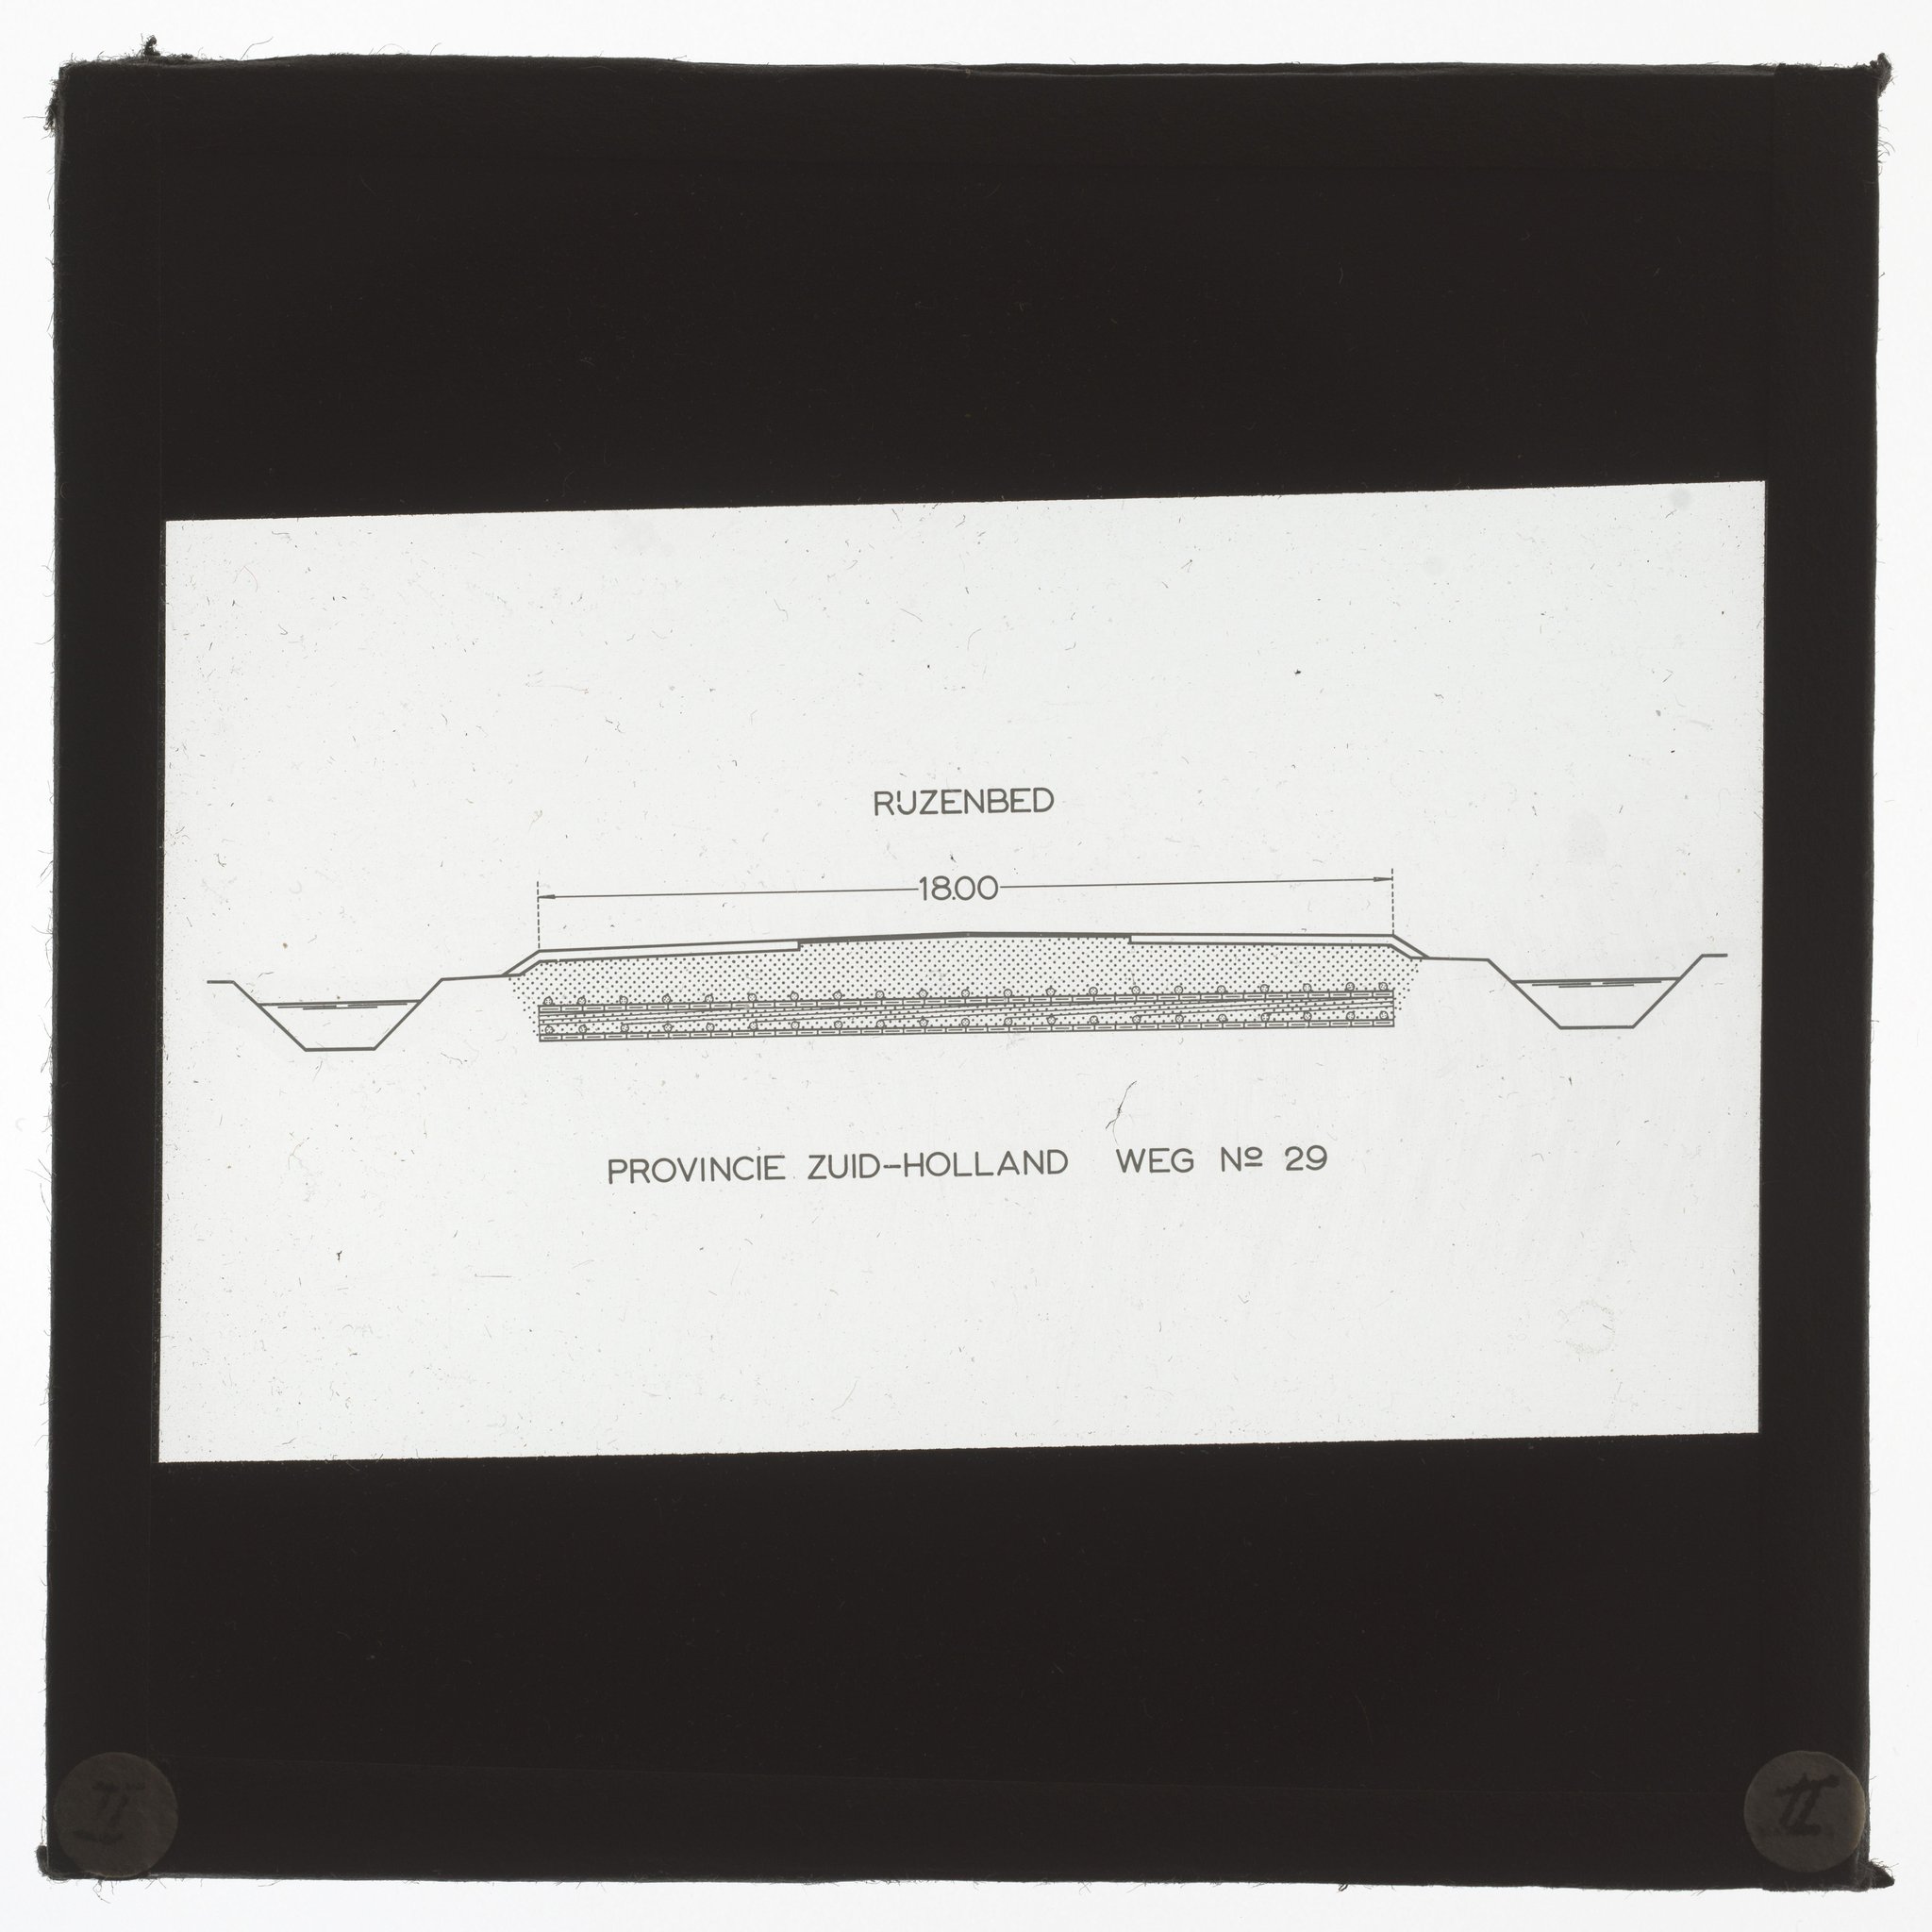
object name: lantern slide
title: Dwarsdoorsnede van de bodem onder een provinciale weg in Zuid-Holland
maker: Anonymous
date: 1956-1960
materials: glass, paper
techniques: printing block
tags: statistic diagram, graph; pictorial chart, etc., public road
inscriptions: number: ‘II’